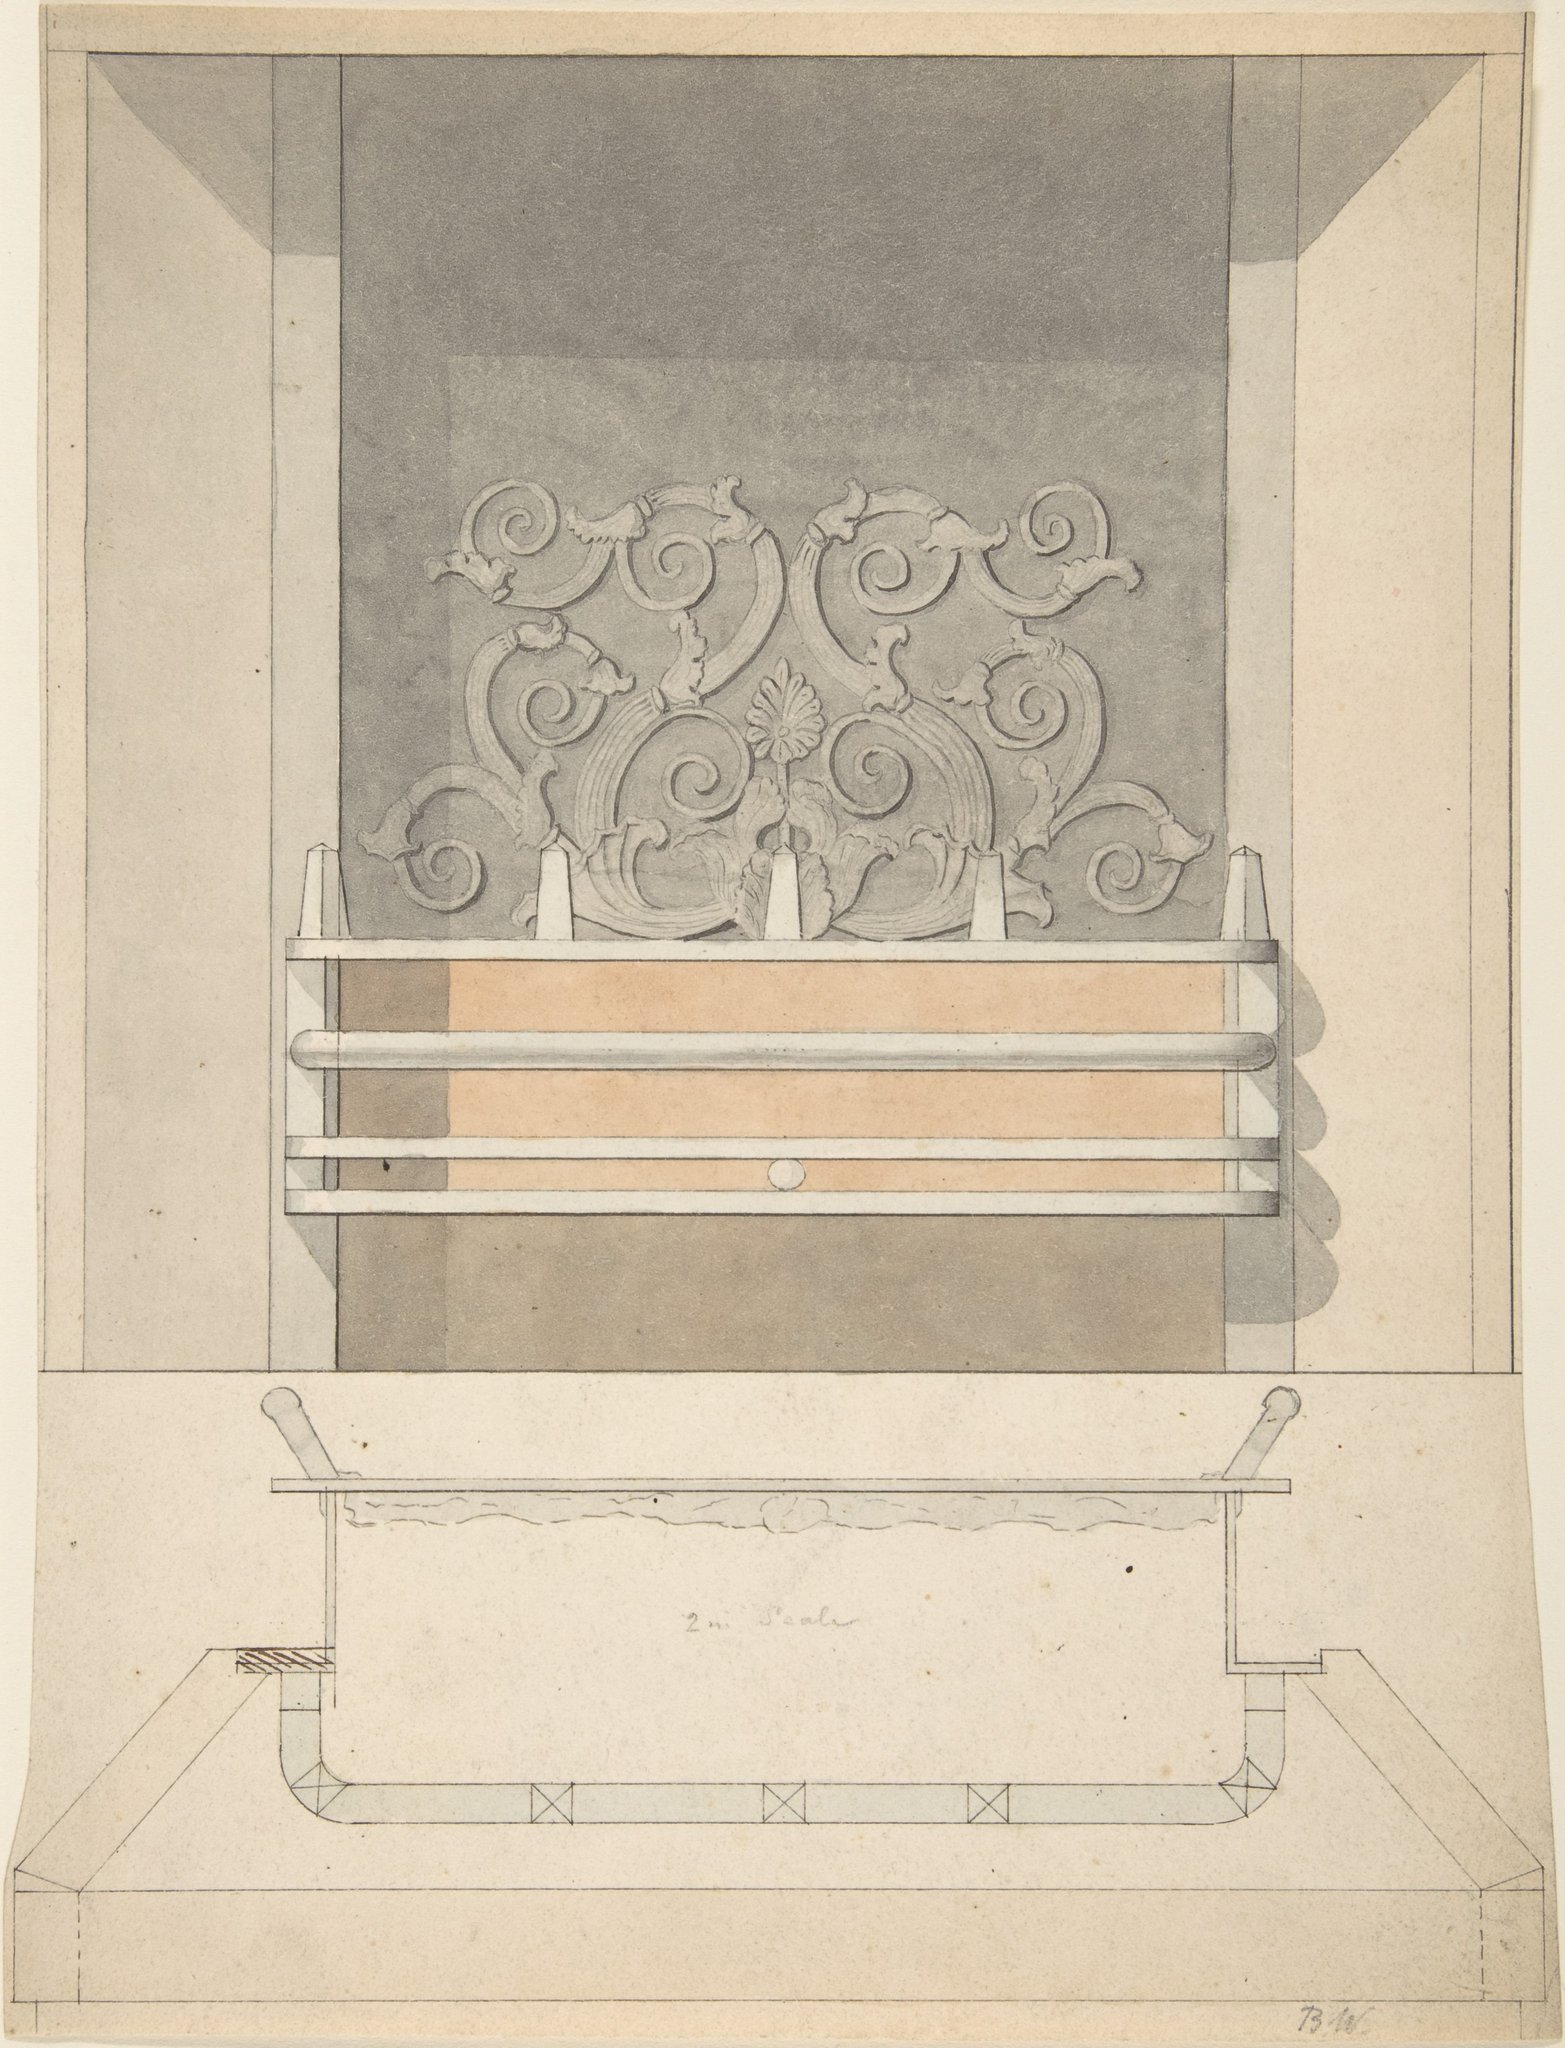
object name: drawing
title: Design for Cast-iron Grate with Green Metal Surround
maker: benjamin dean wyatt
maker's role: artist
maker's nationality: british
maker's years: 1775-1850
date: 1814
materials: ink, watercolor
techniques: brush, pen, wash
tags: ornament